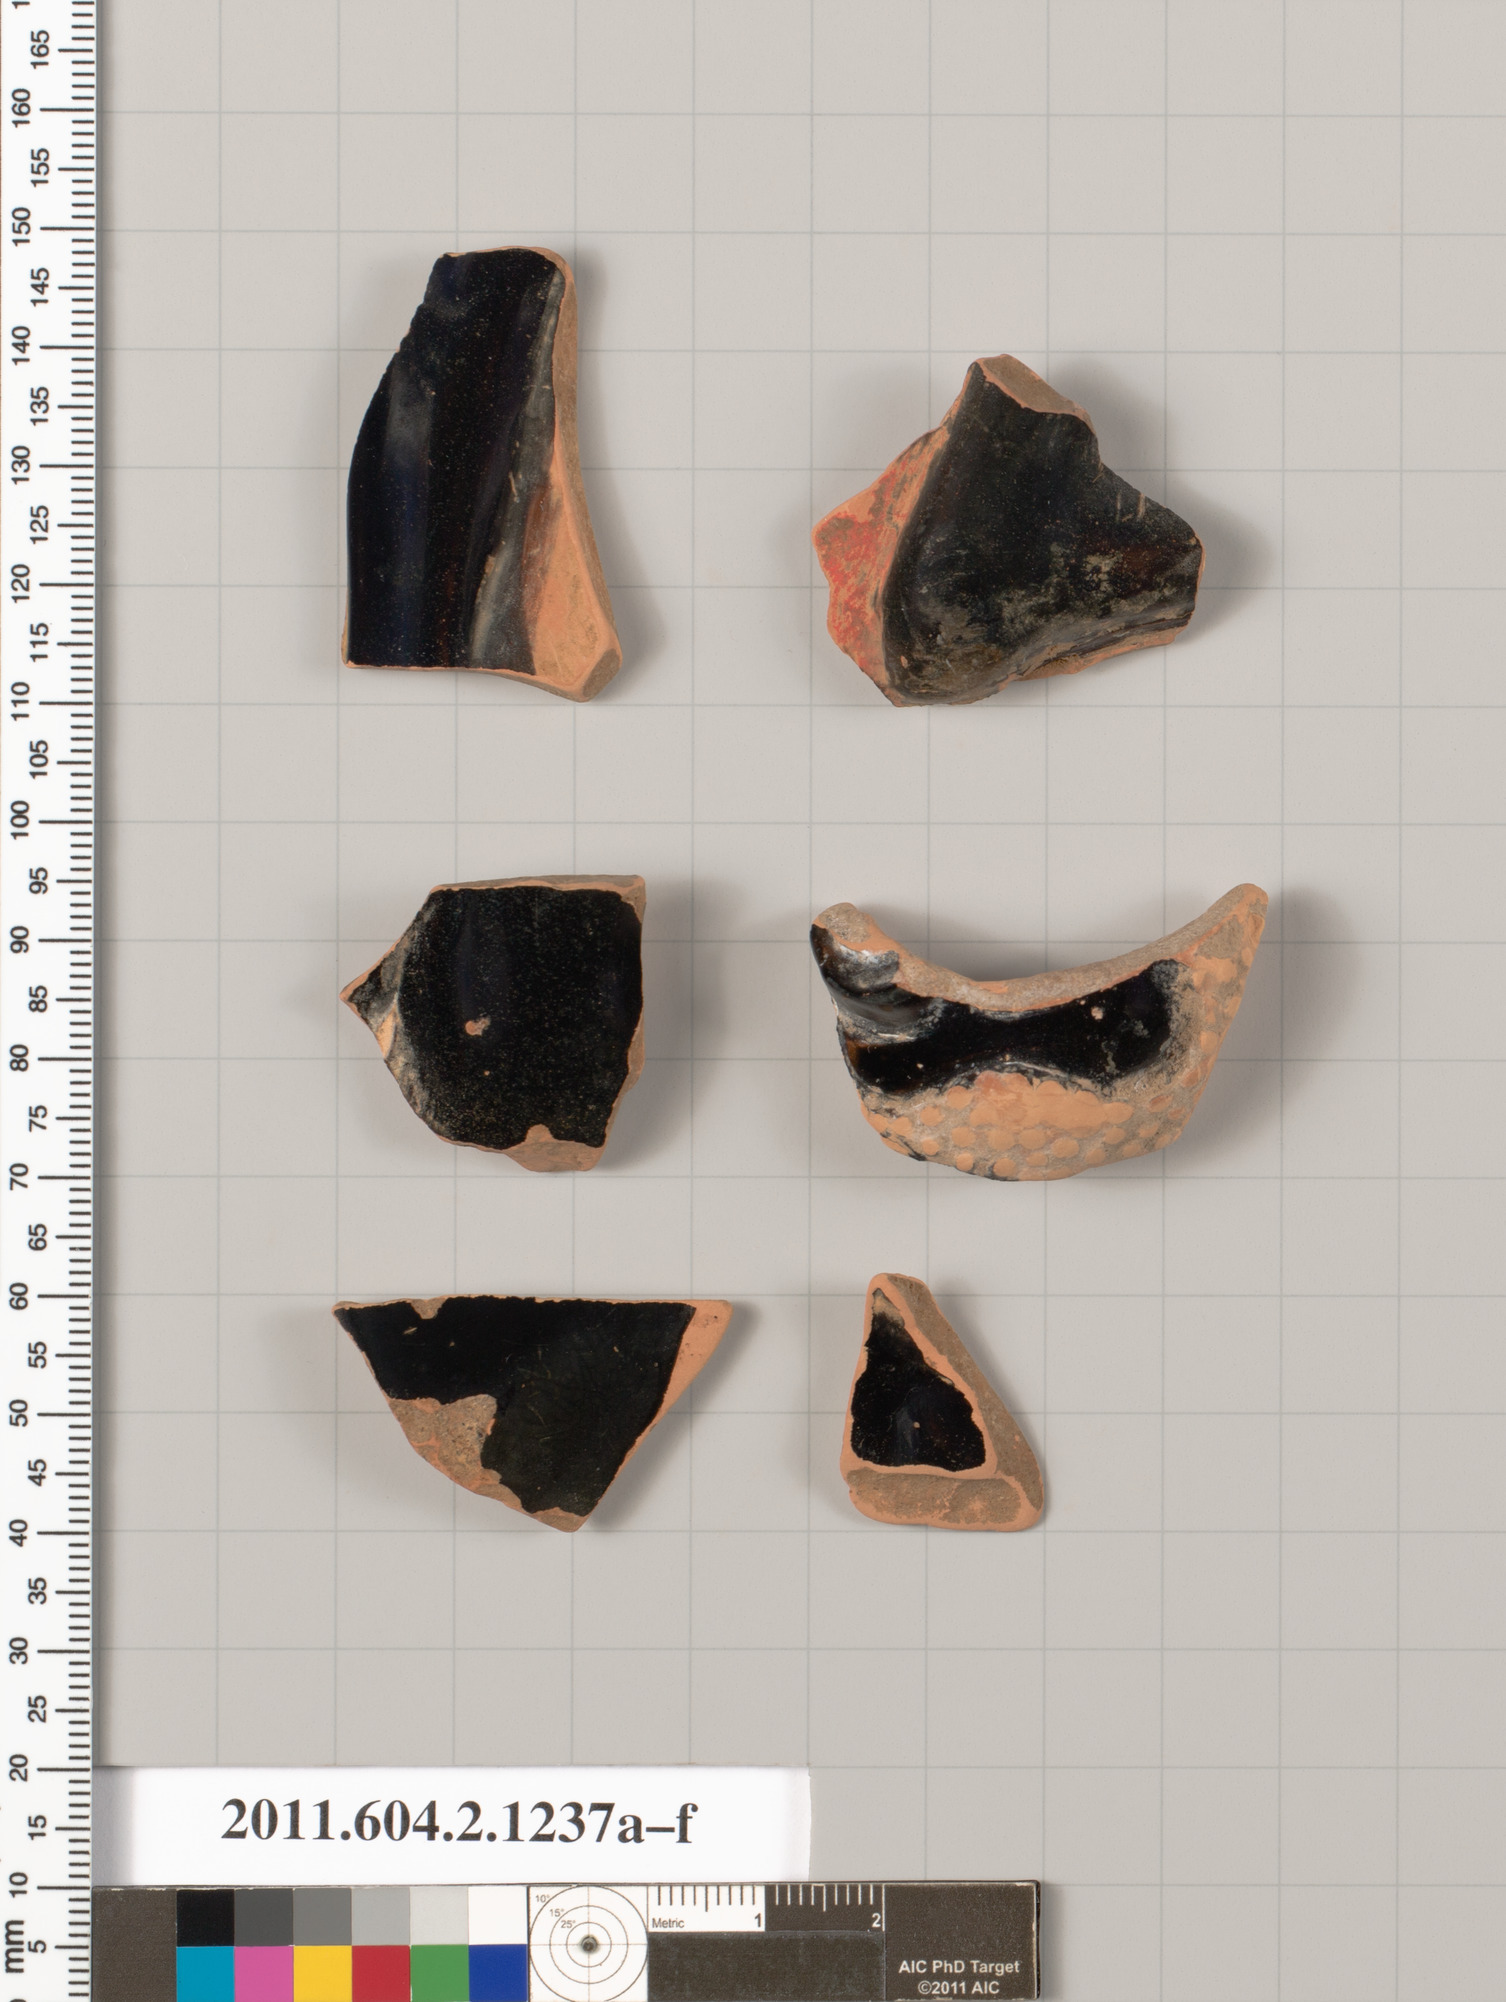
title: Terracotta fragments from a plastic vase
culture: greek, attic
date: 467-435 BCE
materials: terracotta